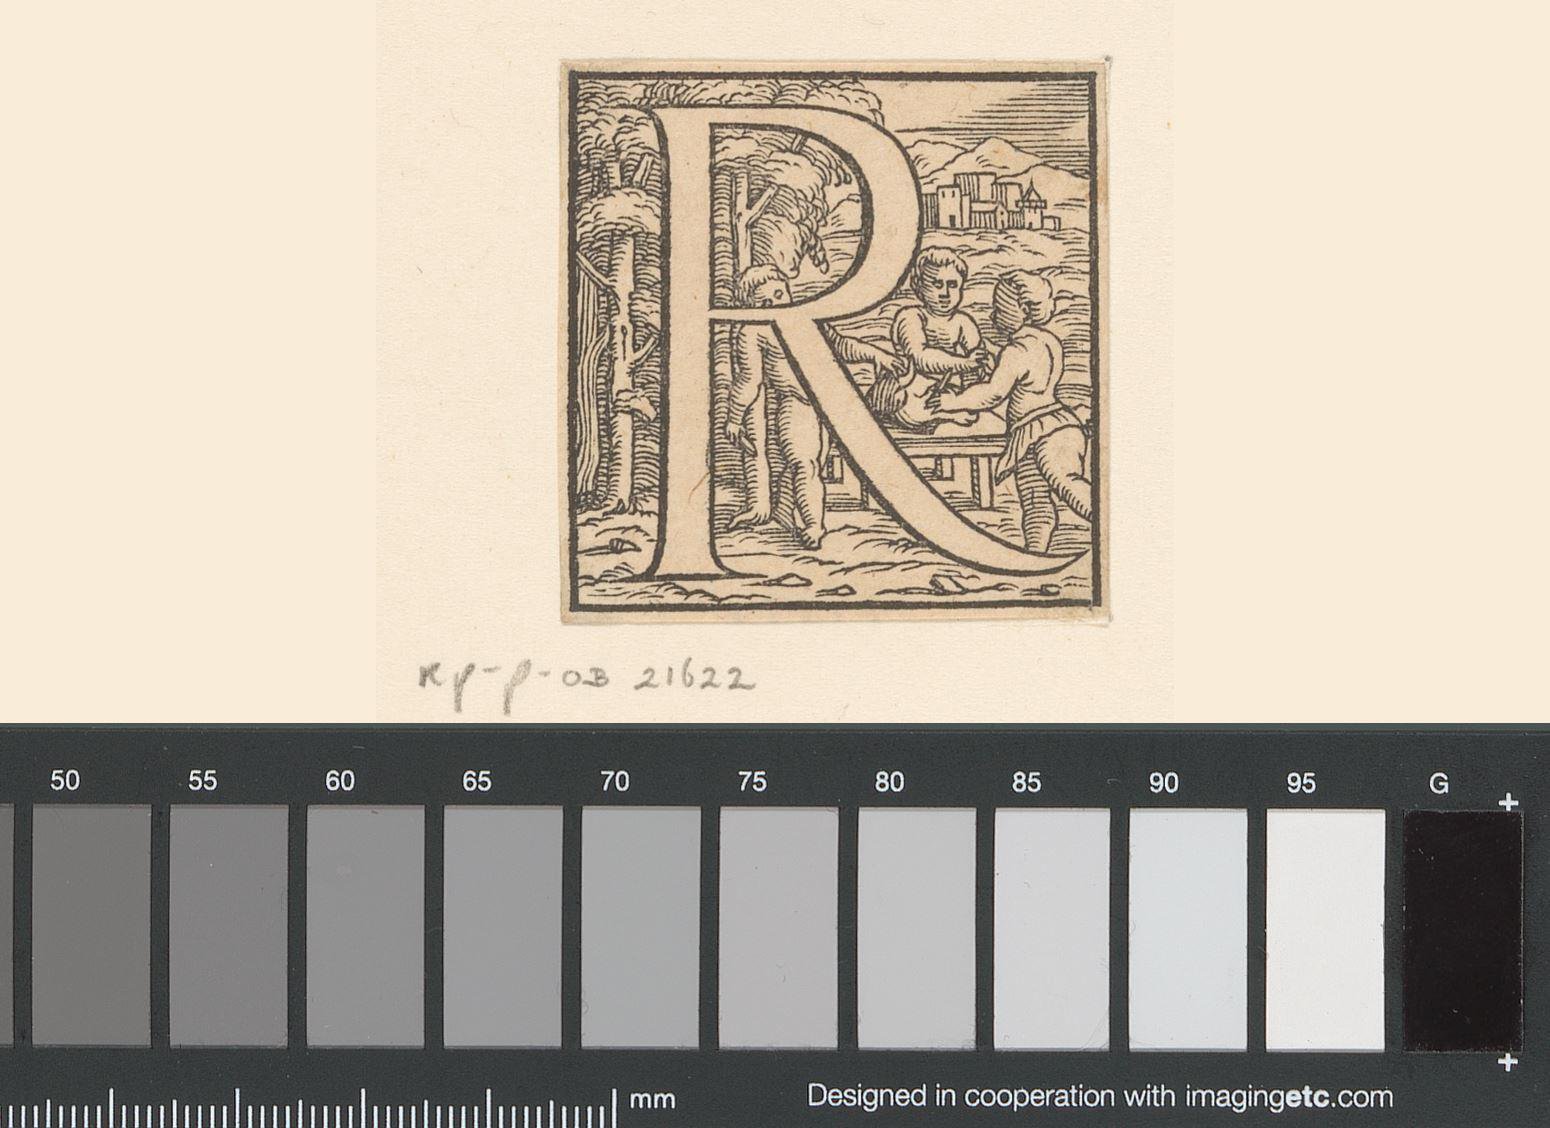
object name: book illustration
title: Versierde initialen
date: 1543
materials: paper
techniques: woodcut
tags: cow, letters, alphabet, script, physiology and anatomy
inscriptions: collector's mark: Lugt 2227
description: Prent uit: Vesalius, Andreas. De Humani Corporis Fabrica. Bazel: Jan Herpst, 1543.